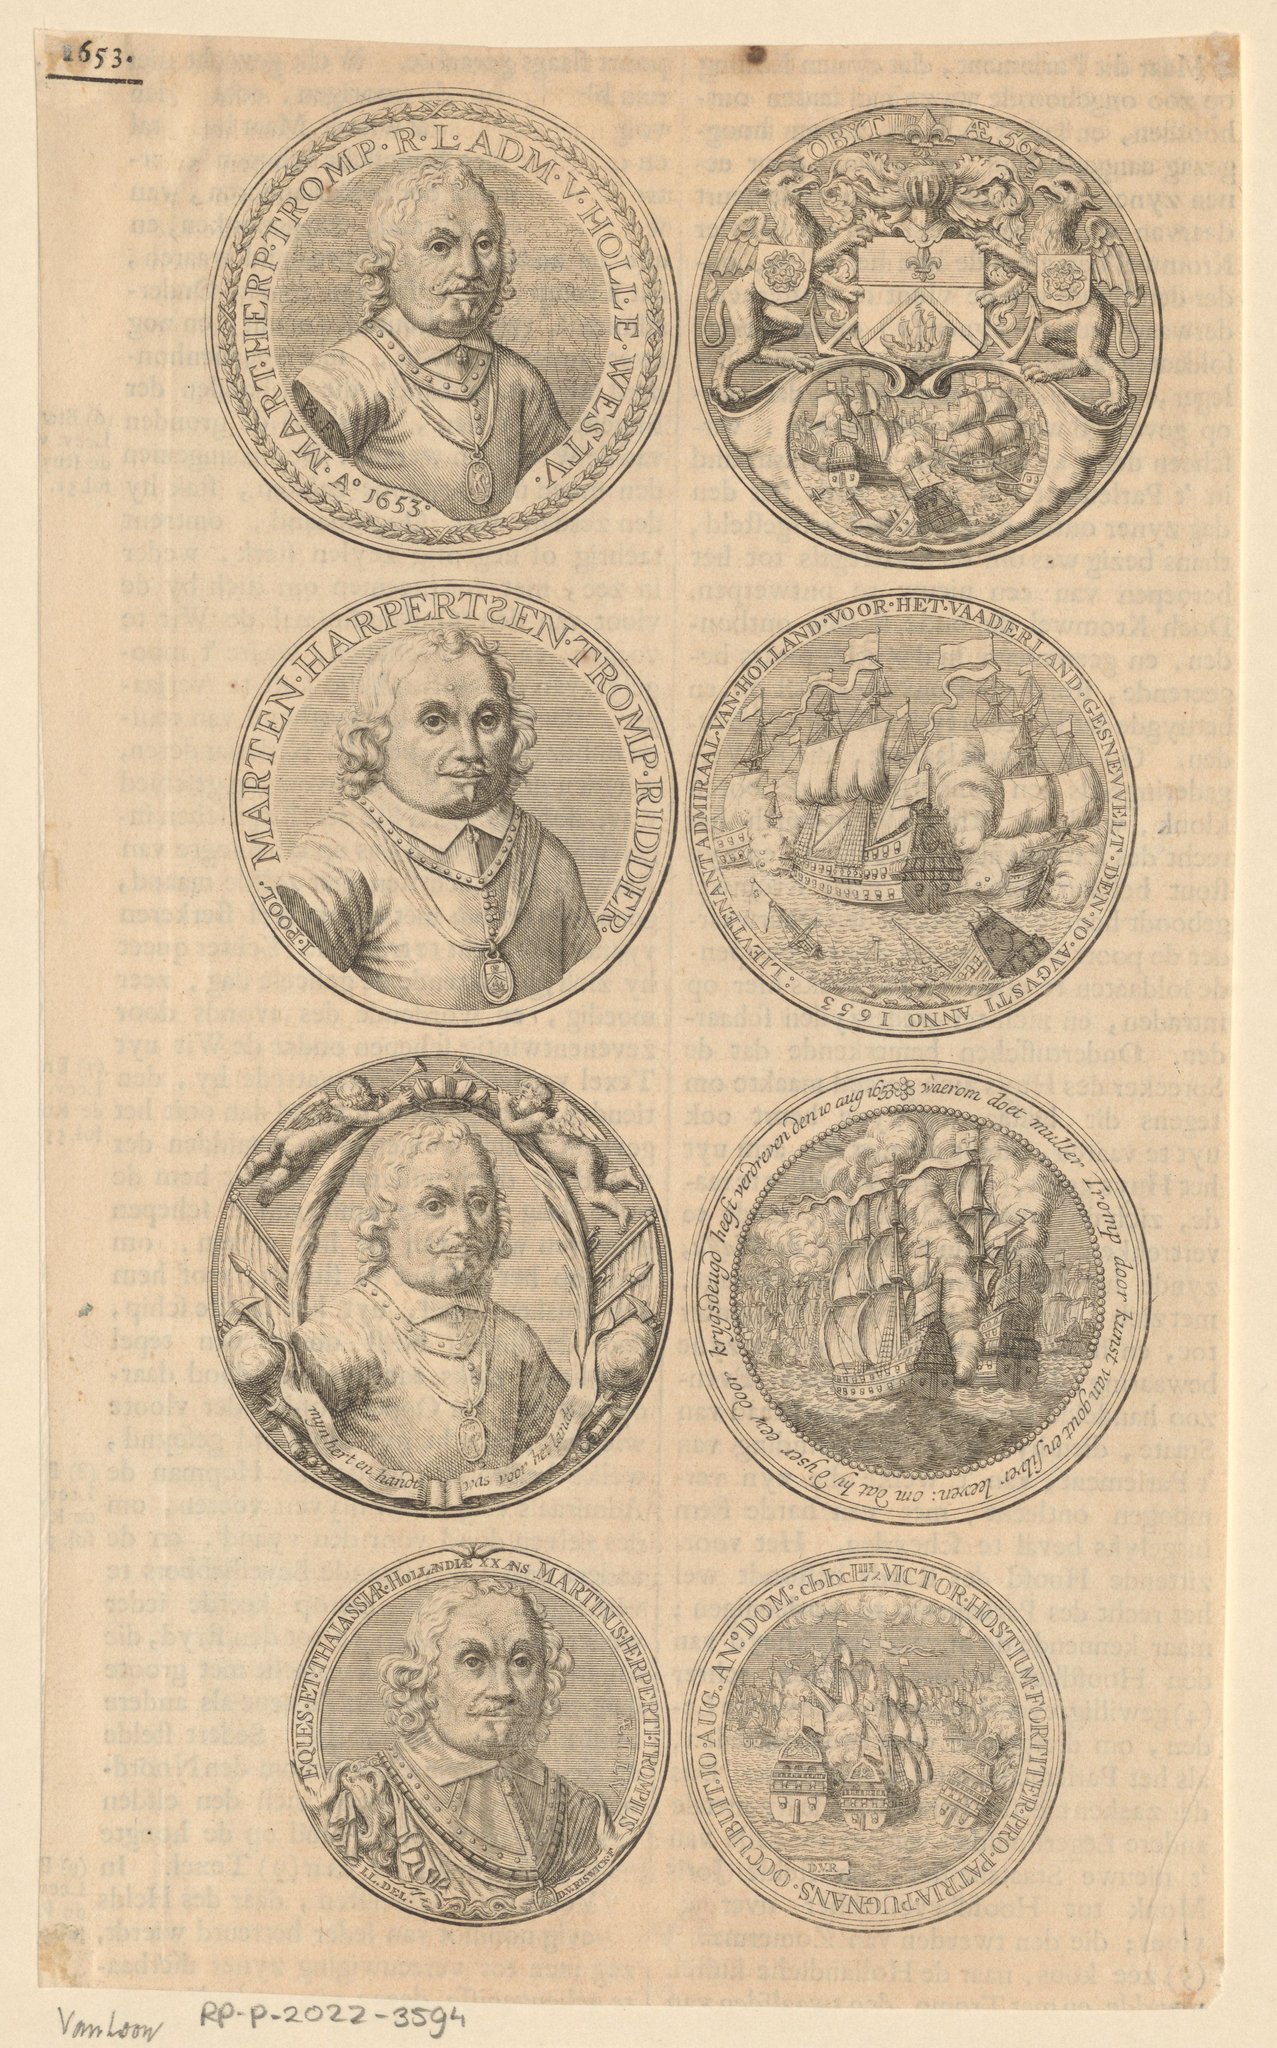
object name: book illustration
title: Voor- en achterzijdes van vier penningen met portretten van Maarten Hapertszoon Tromp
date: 1726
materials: paper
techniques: etching, letterpress printing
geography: northern netherlands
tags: brielle, maarten harpertszoon tromp, historical persons, pendant, trinket, 'breloque', commander-in-chief, admiral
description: Prent uit: Loon, Gerard van. Beschryving der Nederlandsche Historipenningen: (...). Den Haag: Christiaan van Lom et al., 1726, dl. 2, p. 376.